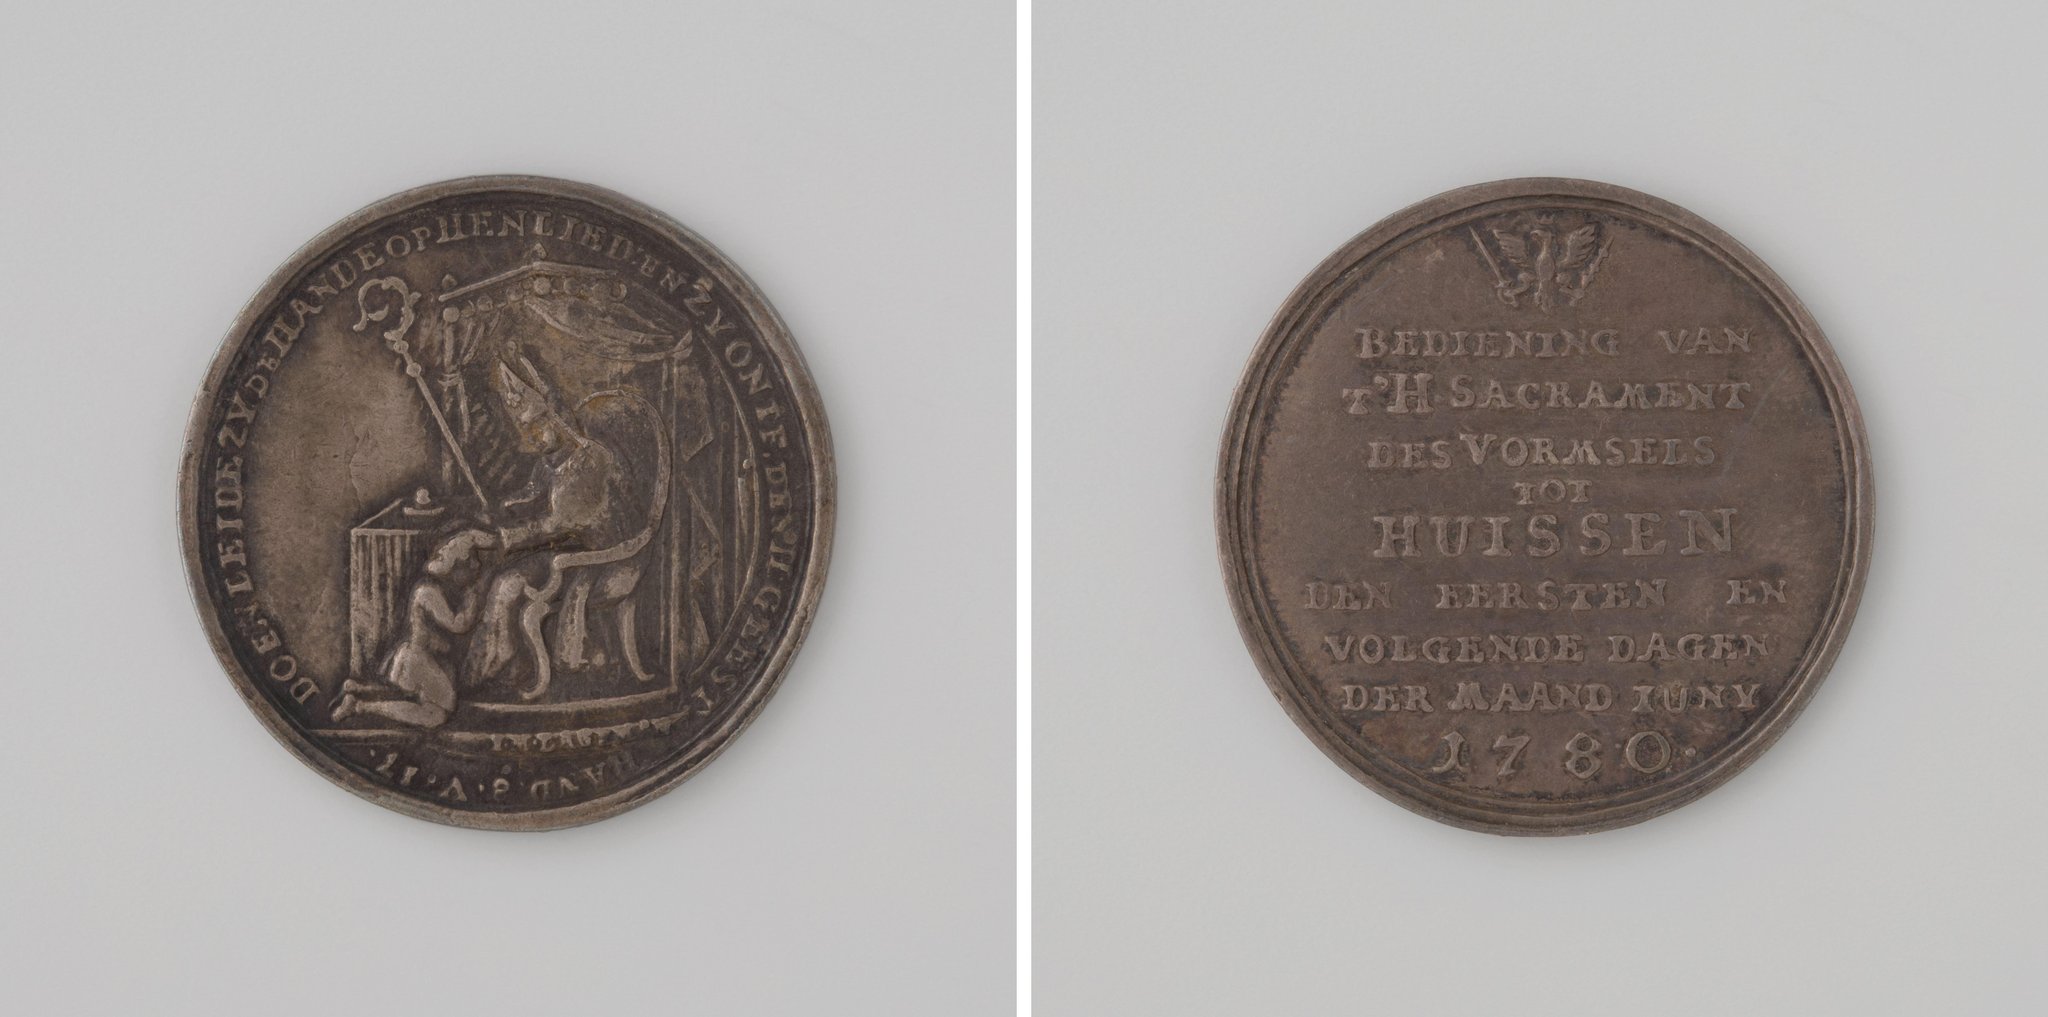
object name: history medal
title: Bediening van het sacrament van het H. Vormsel te Huissen door bisschop Cesar Brancadoro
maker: johannes michiel lageman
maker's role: silversmith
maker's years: 1735-1809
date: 1780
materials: silver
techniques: striking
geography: amsterdam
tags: confirmation ~ the second of the seven sacraments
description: Zilveren penning. Voorzijde: bisschop met mijter en staf zit onder troonhemel naast een tafel en legt zijn linkerhand op hoofd van een voor hem knielende persoon binnen omschrift. Keerzijde: opschrift onder gekroonde adelaar met zwaard en scepter in klauwen